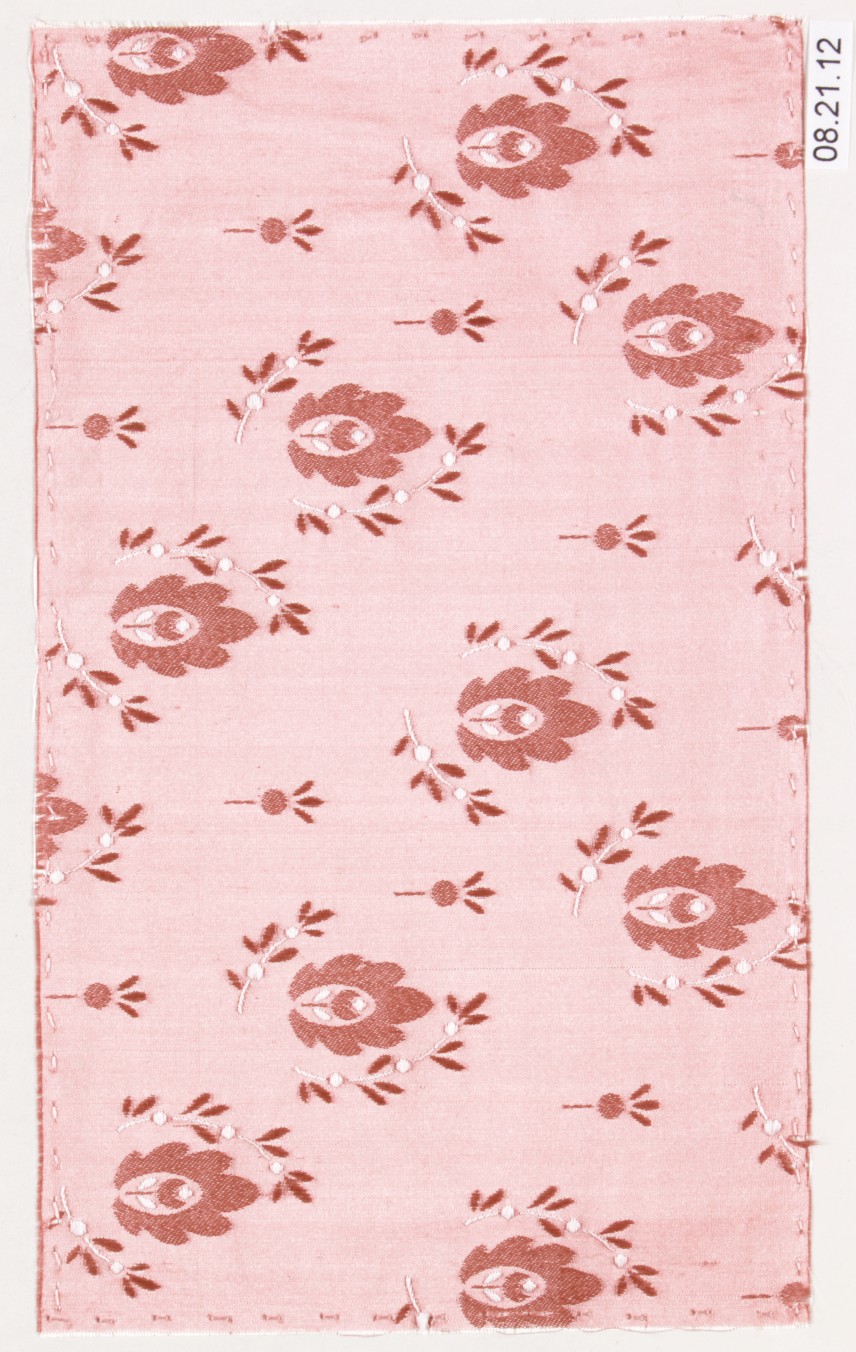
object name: textile sample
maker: Anonymous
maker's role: designer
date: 1900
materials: silk